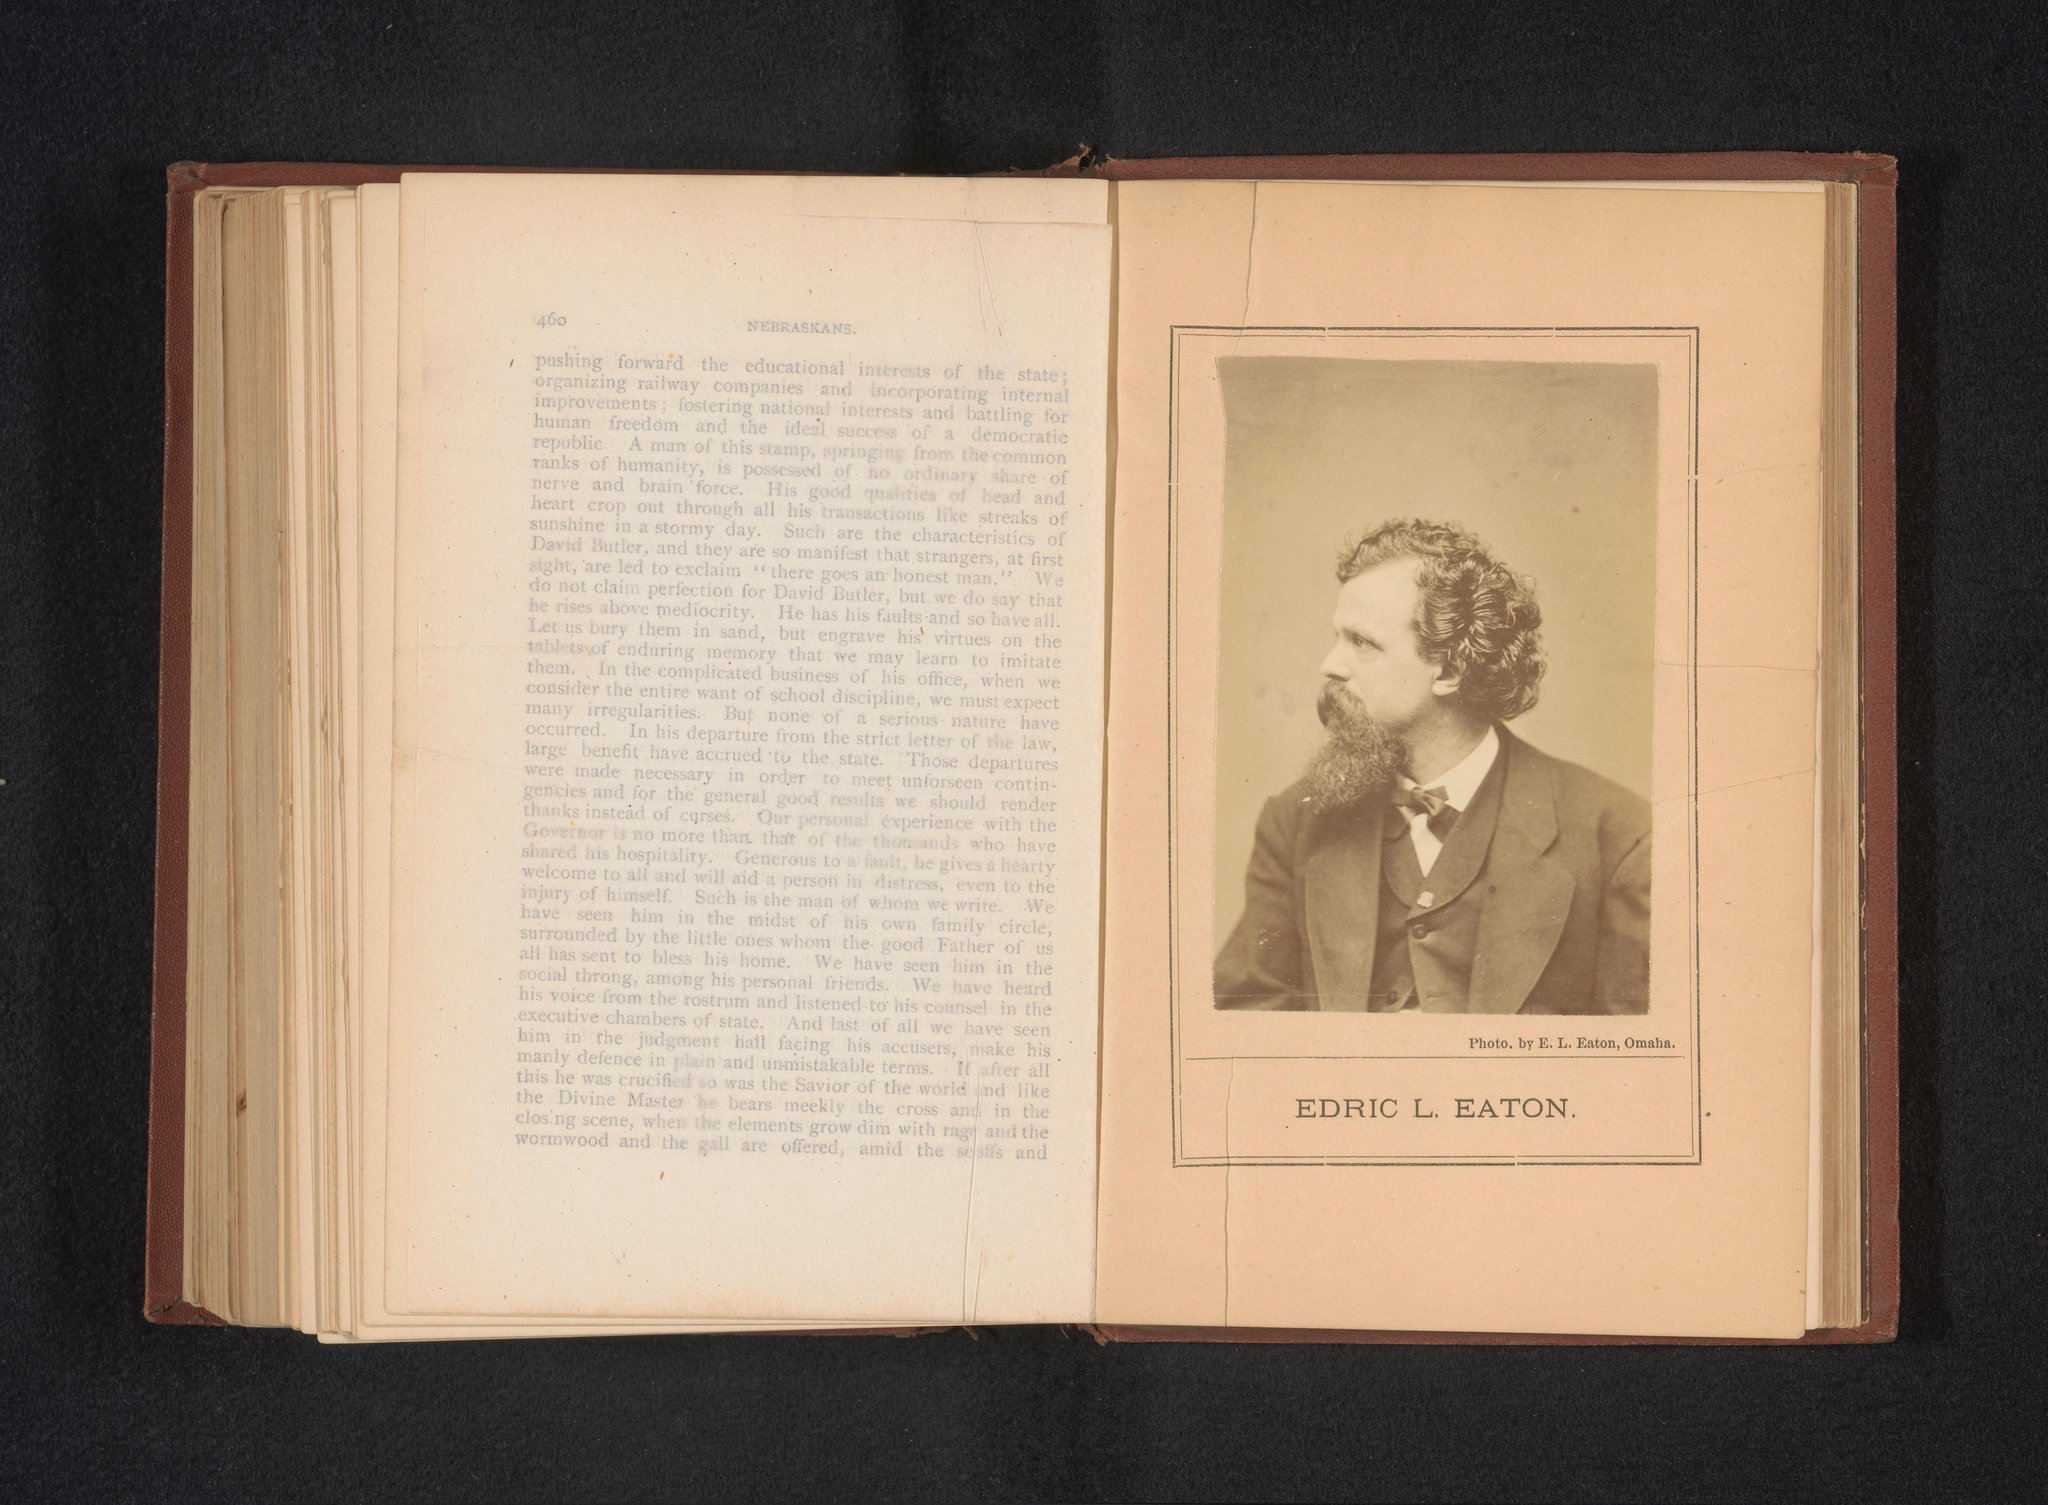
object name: photograph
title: Portret van Edric L. Eaton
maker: edric l. eaton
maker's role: fotograaf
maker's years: 1835-1890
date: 1866-1871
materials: photographic support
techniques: albumen print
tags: edric l. eaton, historical persons